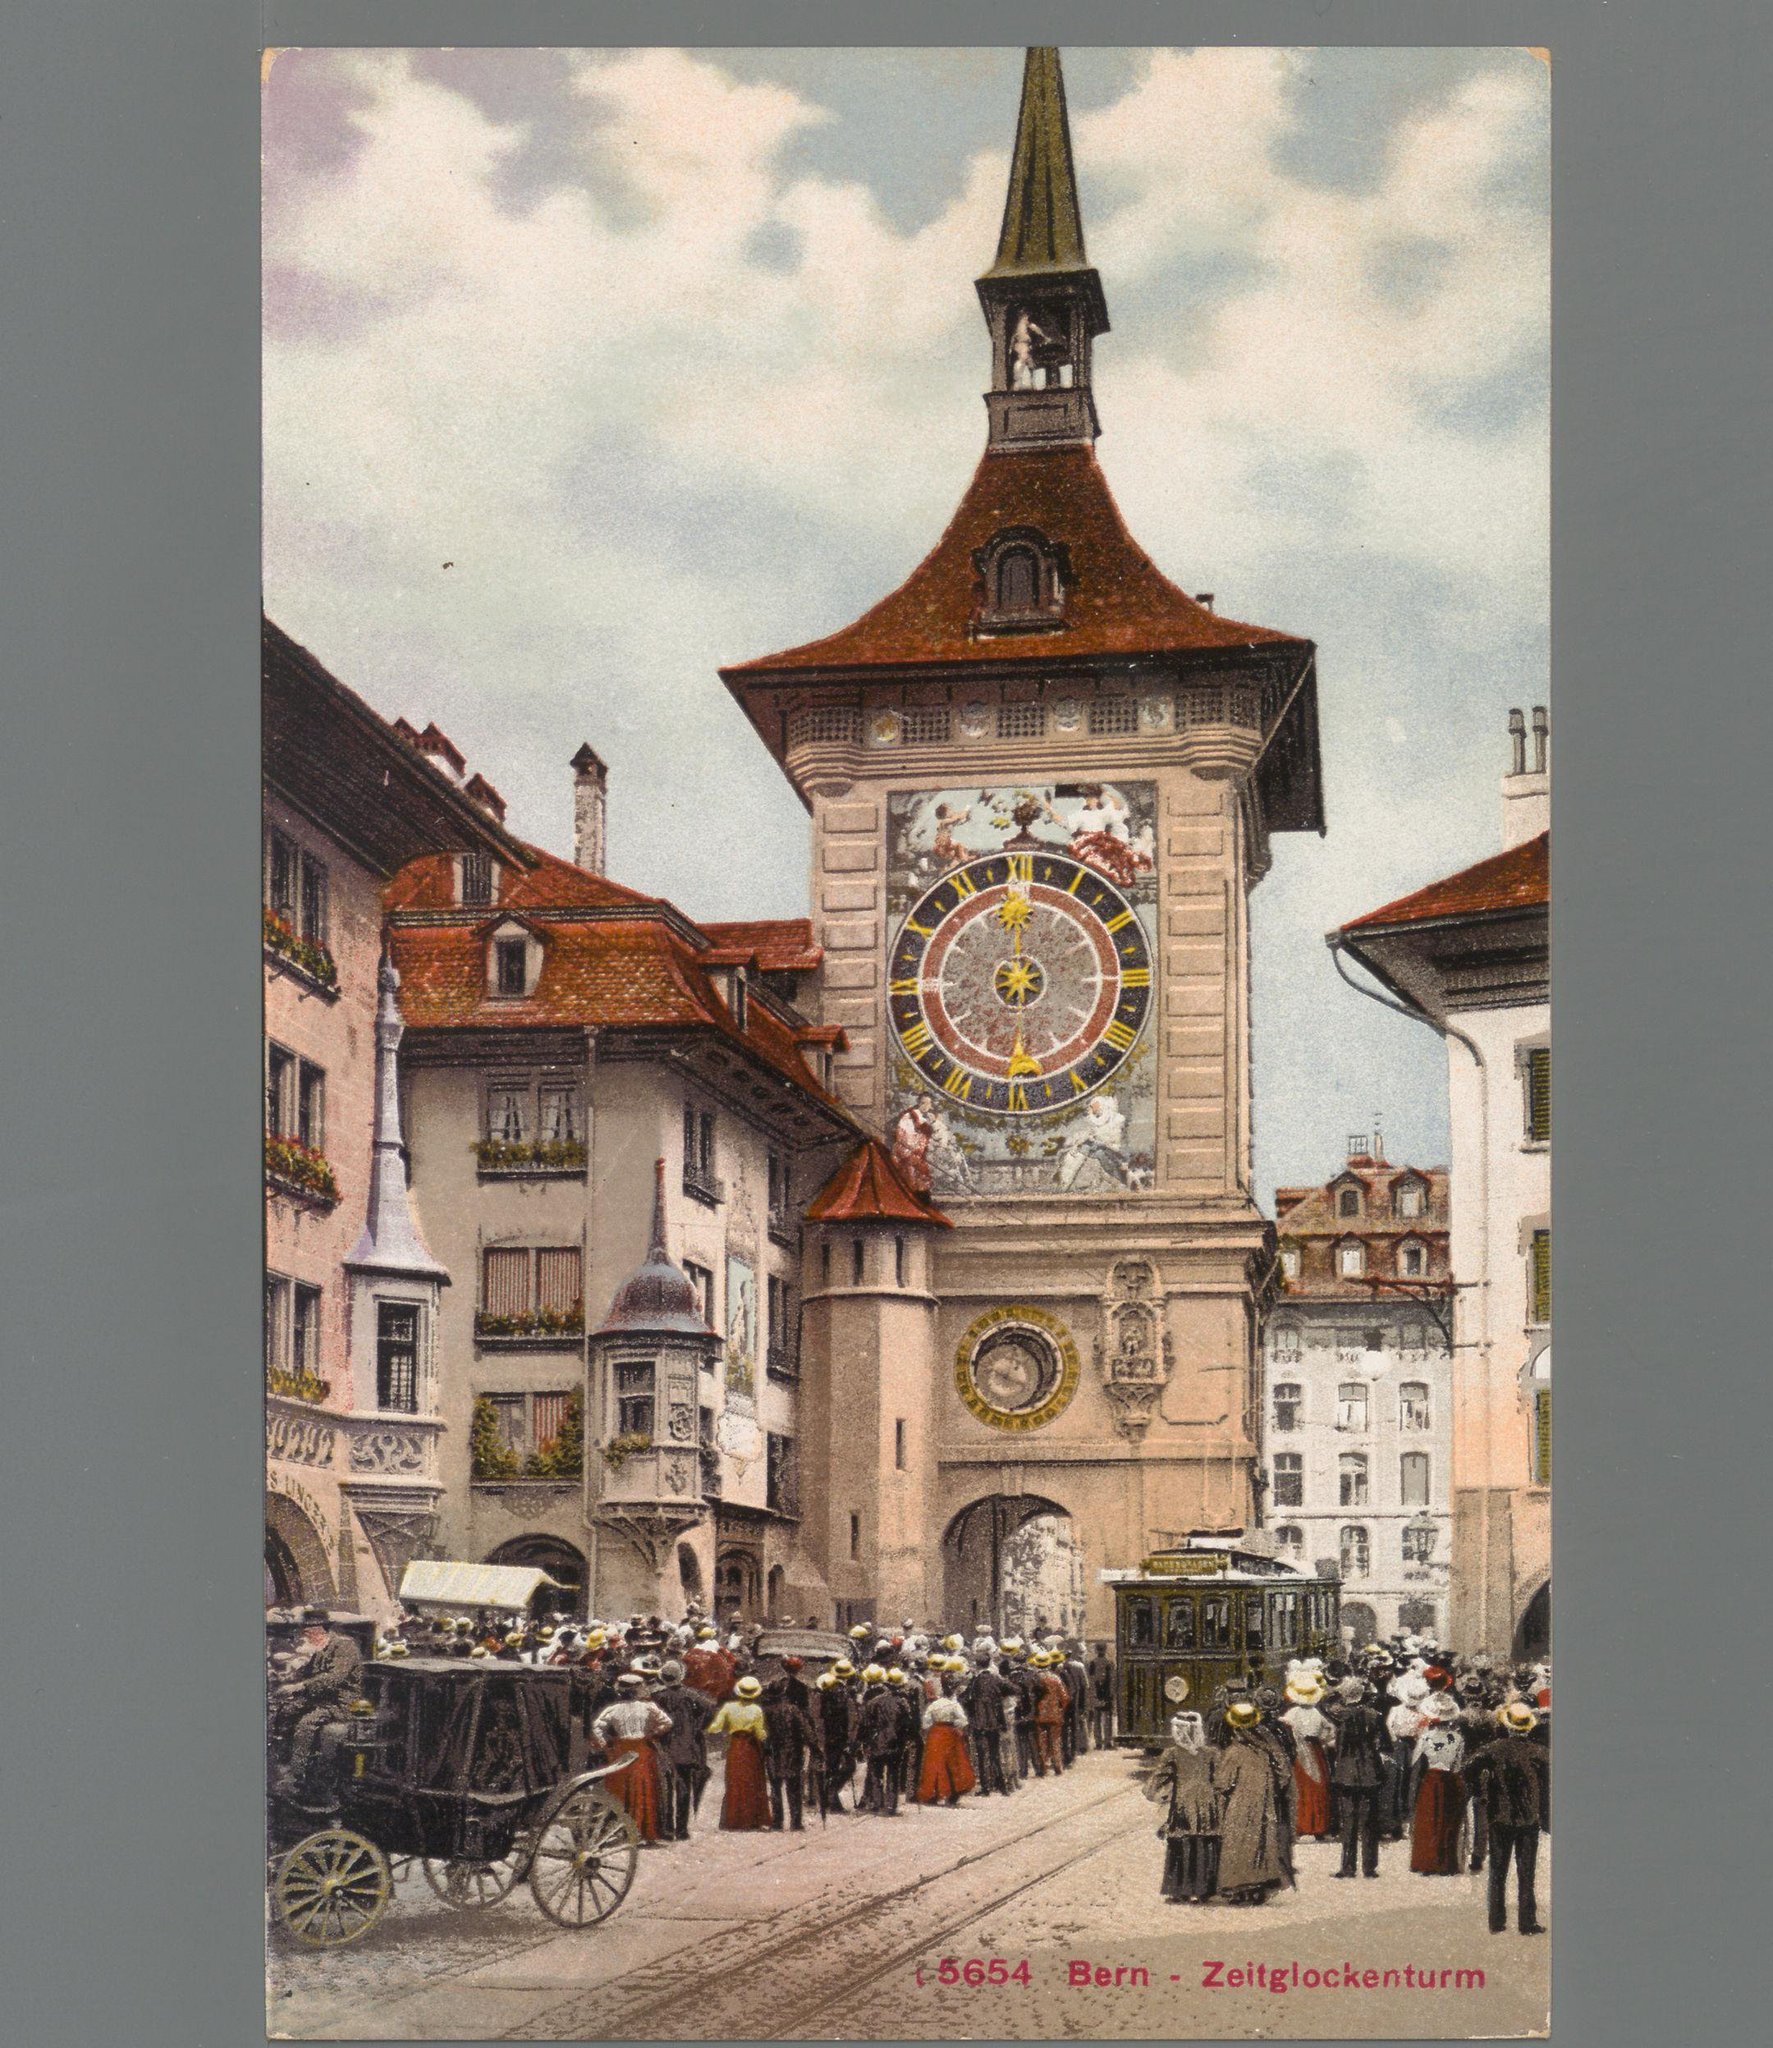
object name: ansichtkaart, prentbriefkaart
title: Bern. Zeitglockenturm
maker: Anonymous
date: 1905-1930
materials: cardboard, photographic process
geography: zurich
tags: tram, square, place, circus, etc. (+ city(-scape) with figures, staffage), tower, clock tower ~ monumental adornment (+ city(-scape) with figures, staffage)